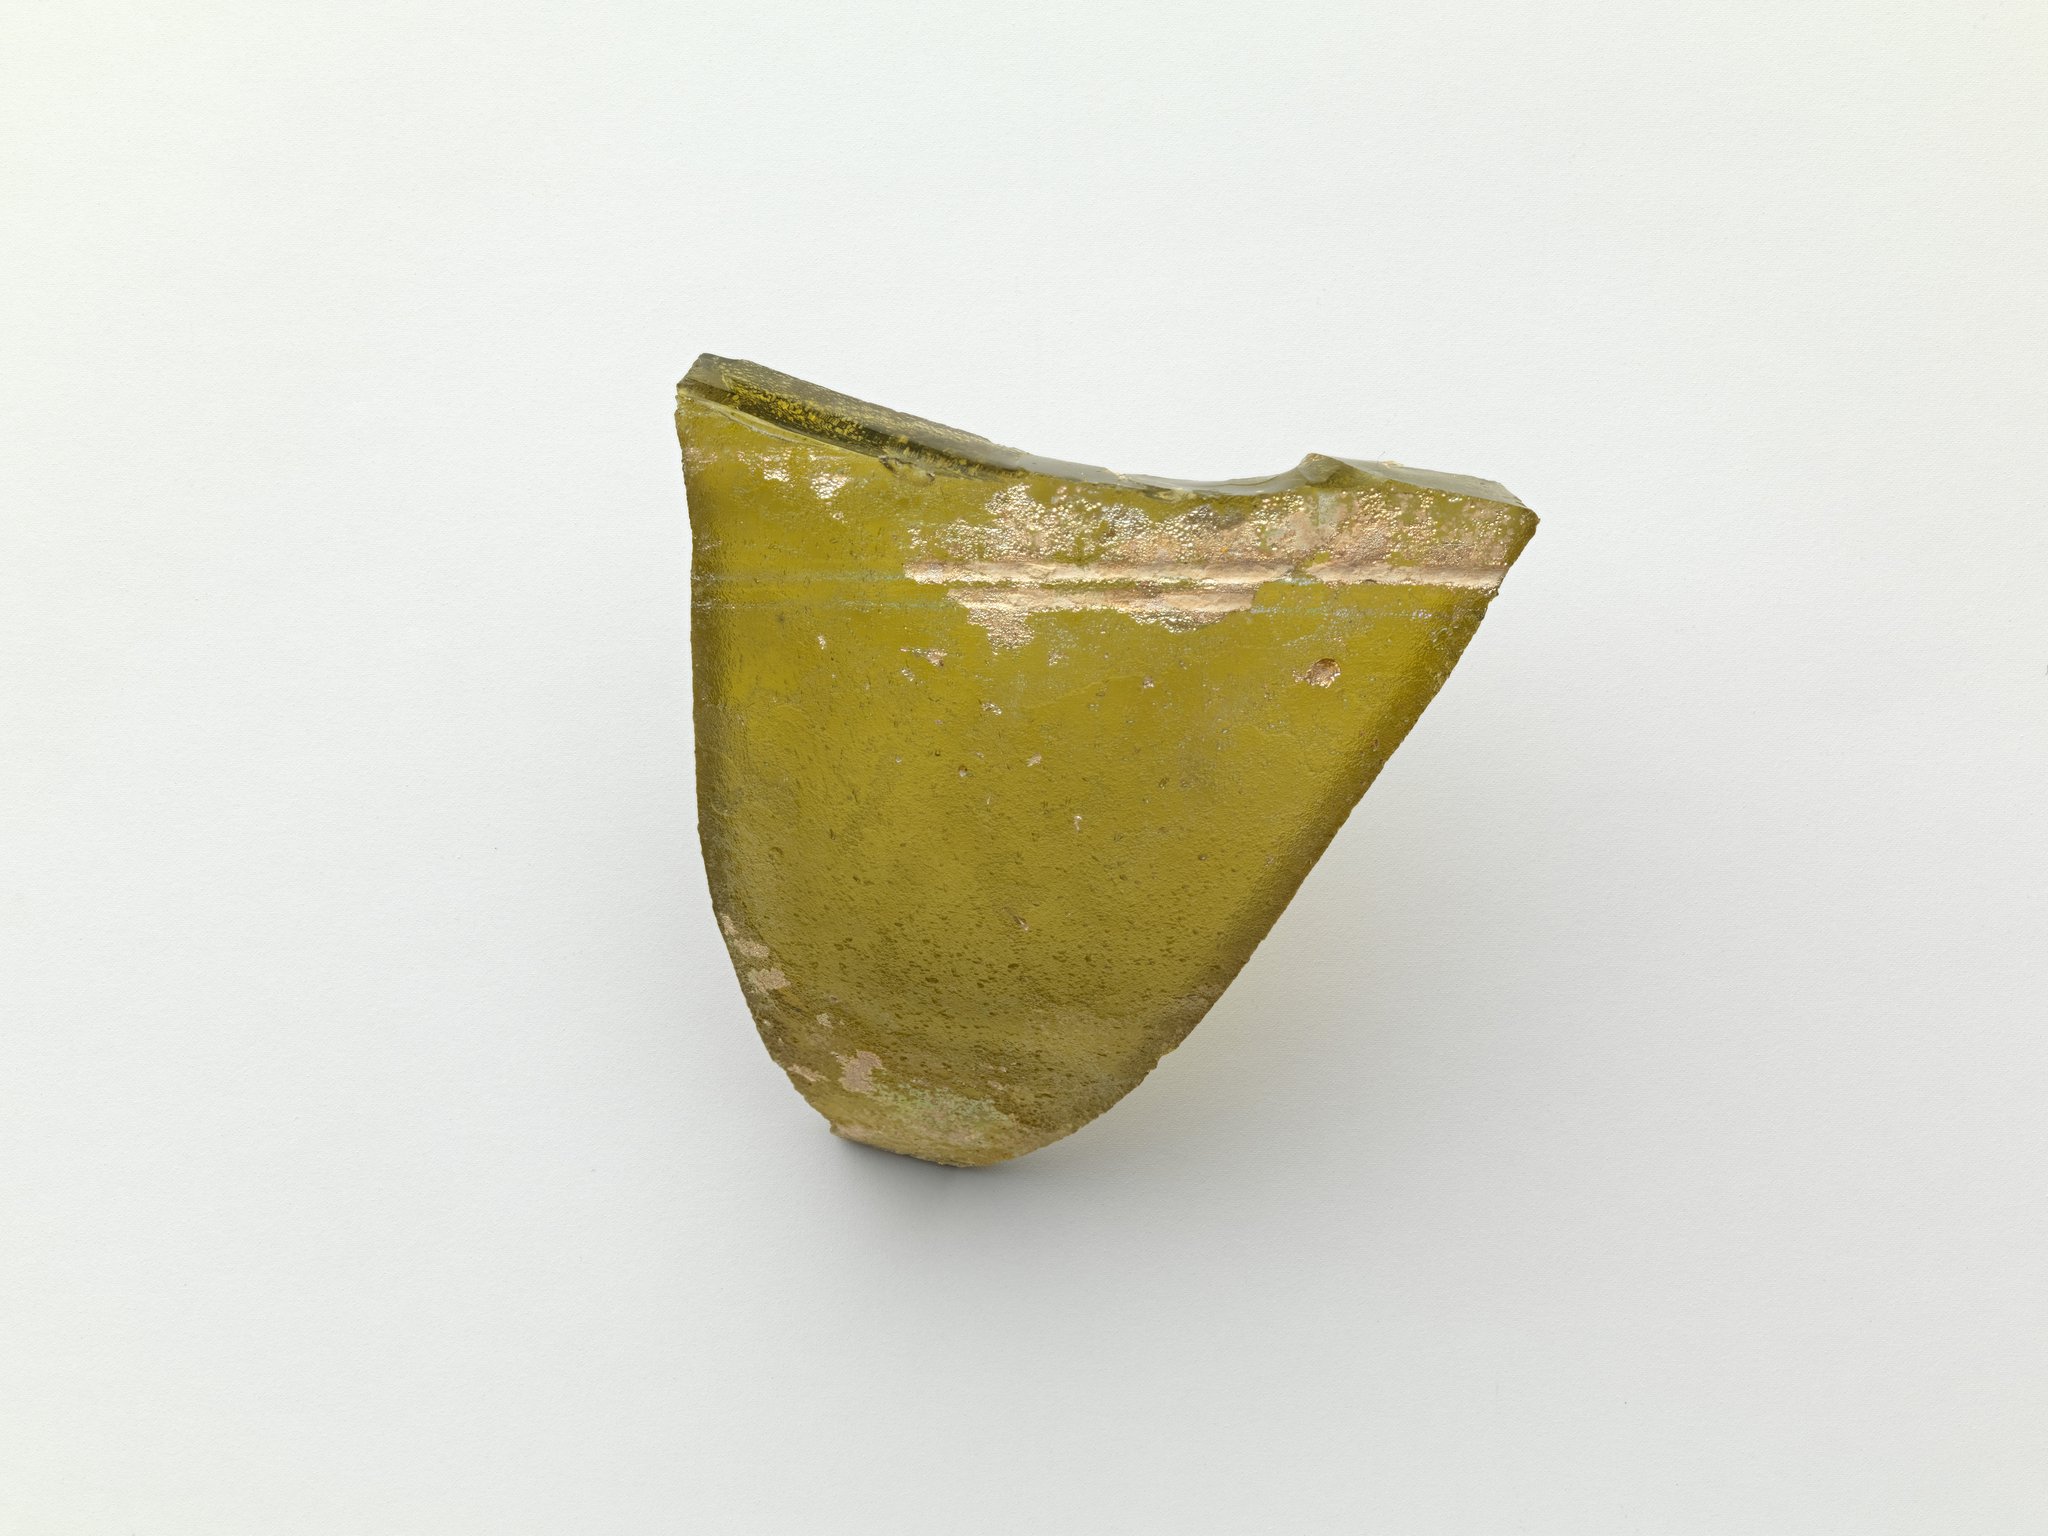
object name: fragment of a bowl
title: Glass bowl fragment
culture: greek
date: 167-68 BCE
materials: glass